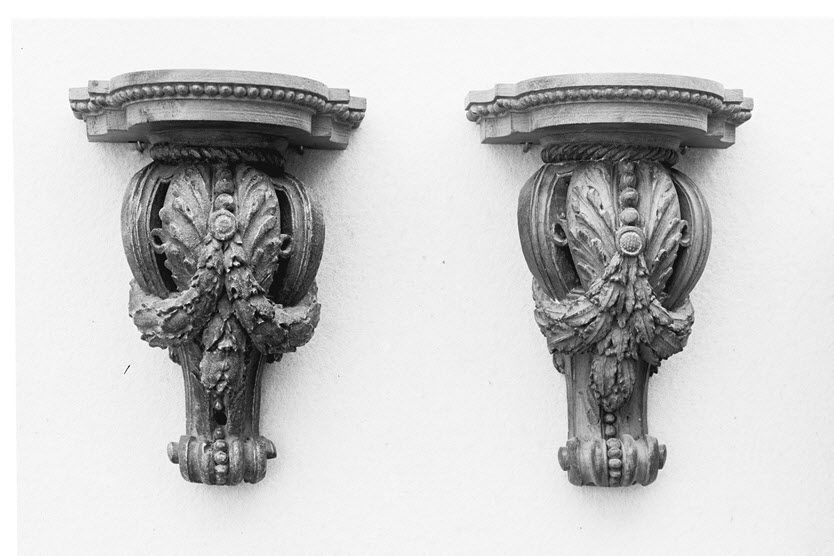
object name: console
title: Pair of consoles (consoles d'appliques)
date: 1701-1800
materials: wood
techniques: gilding